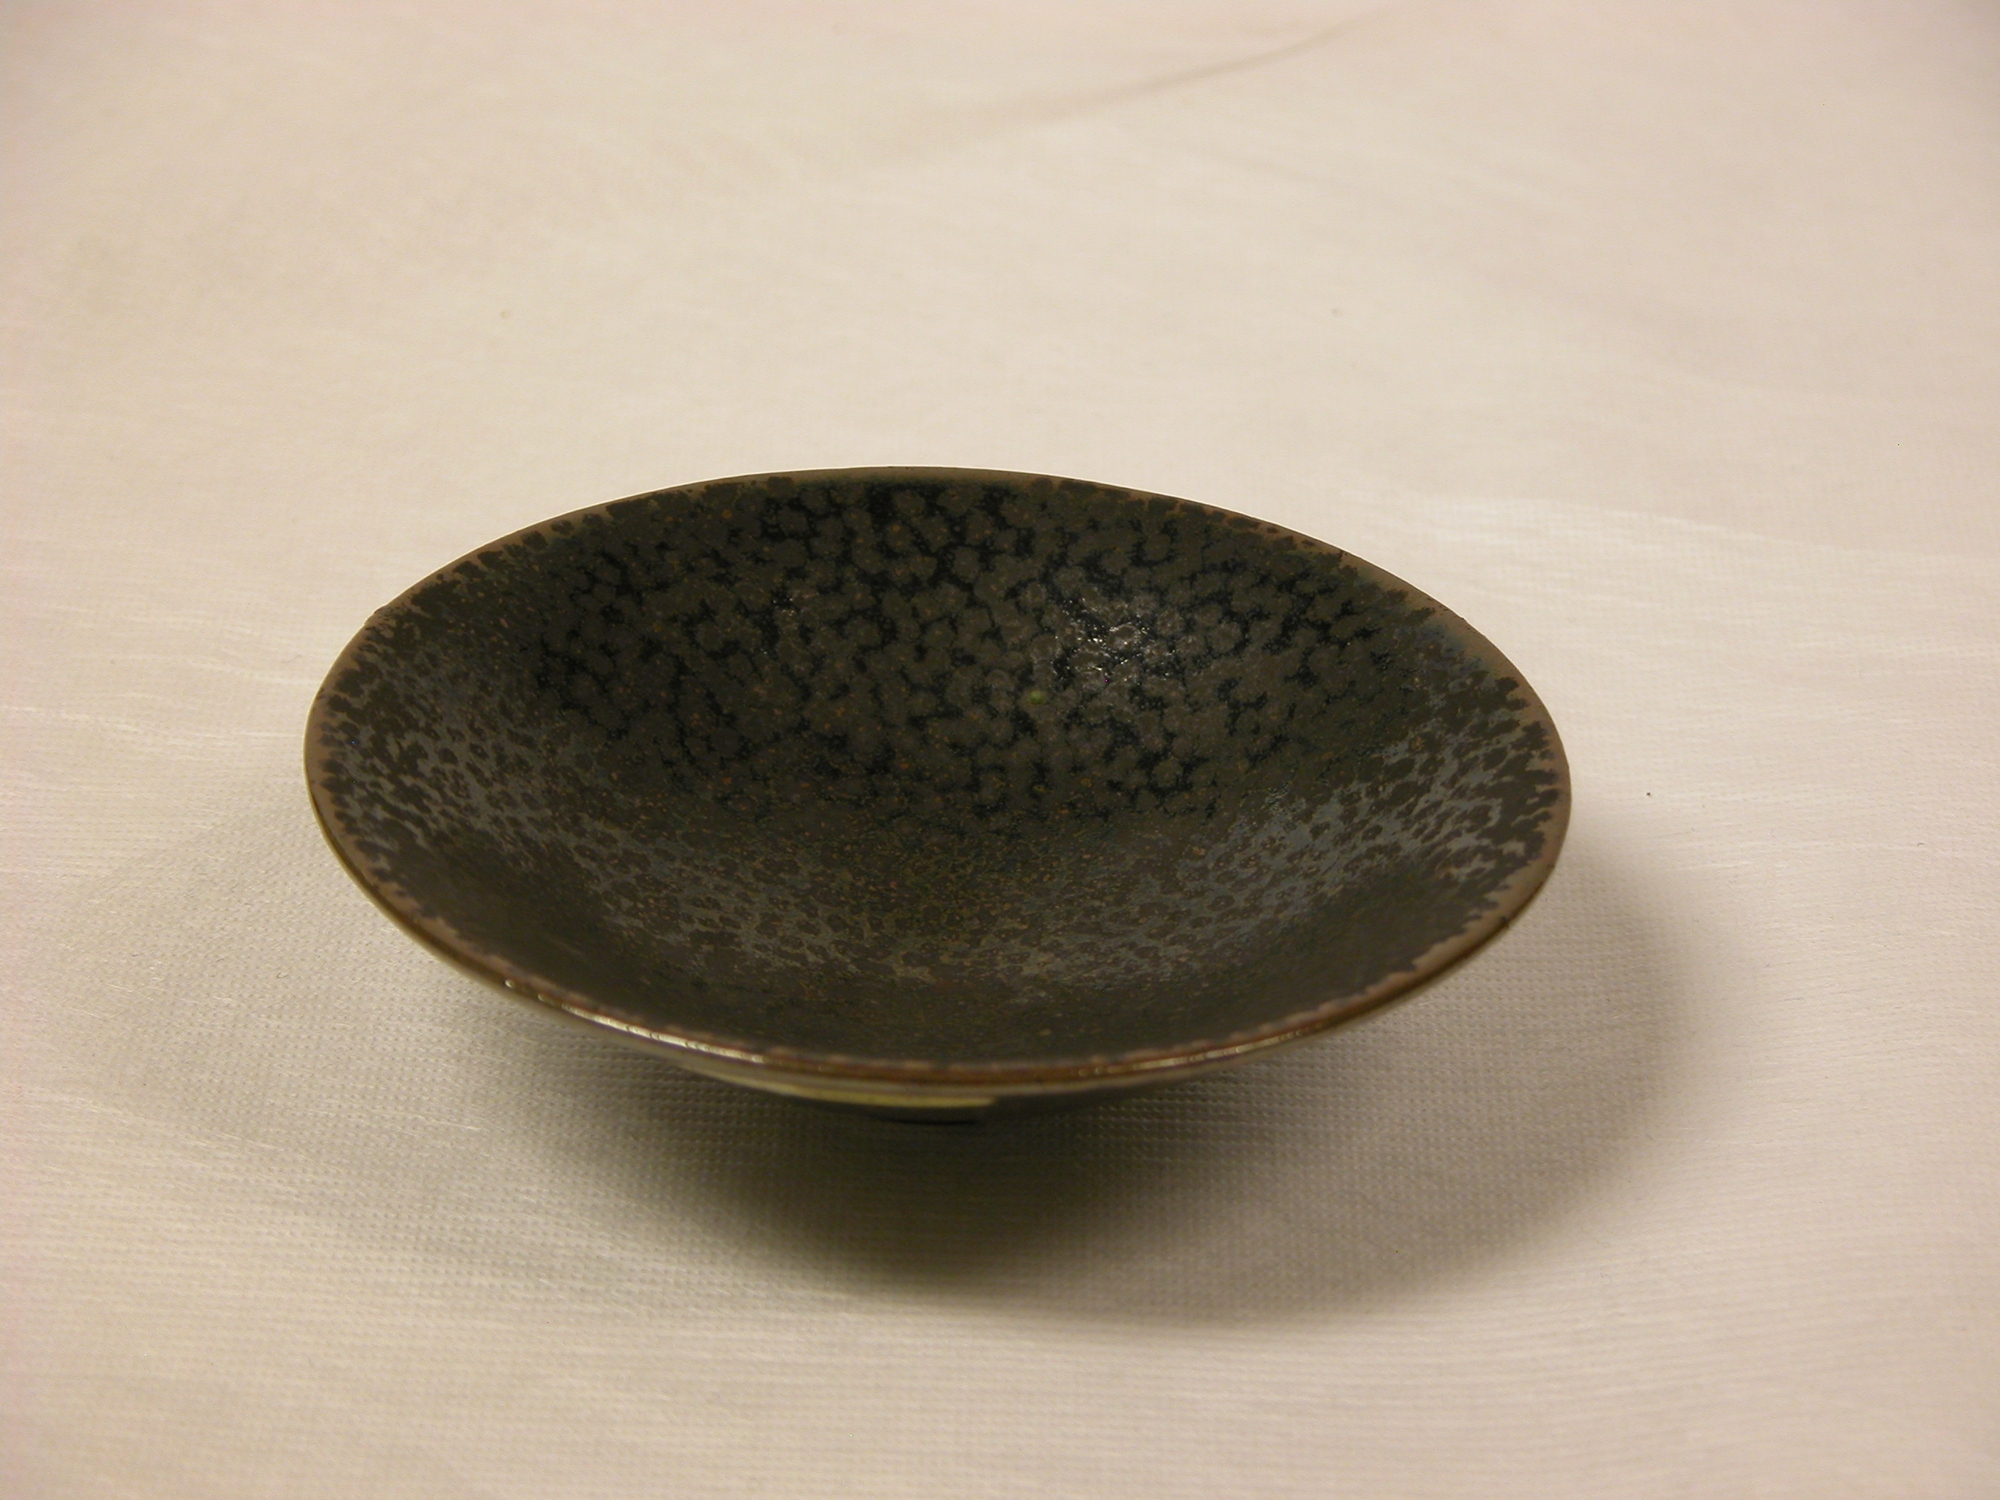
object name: bowl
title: Bowl (one of a pair)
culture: chinese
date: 960-1279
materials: fur, glaze, stoneware